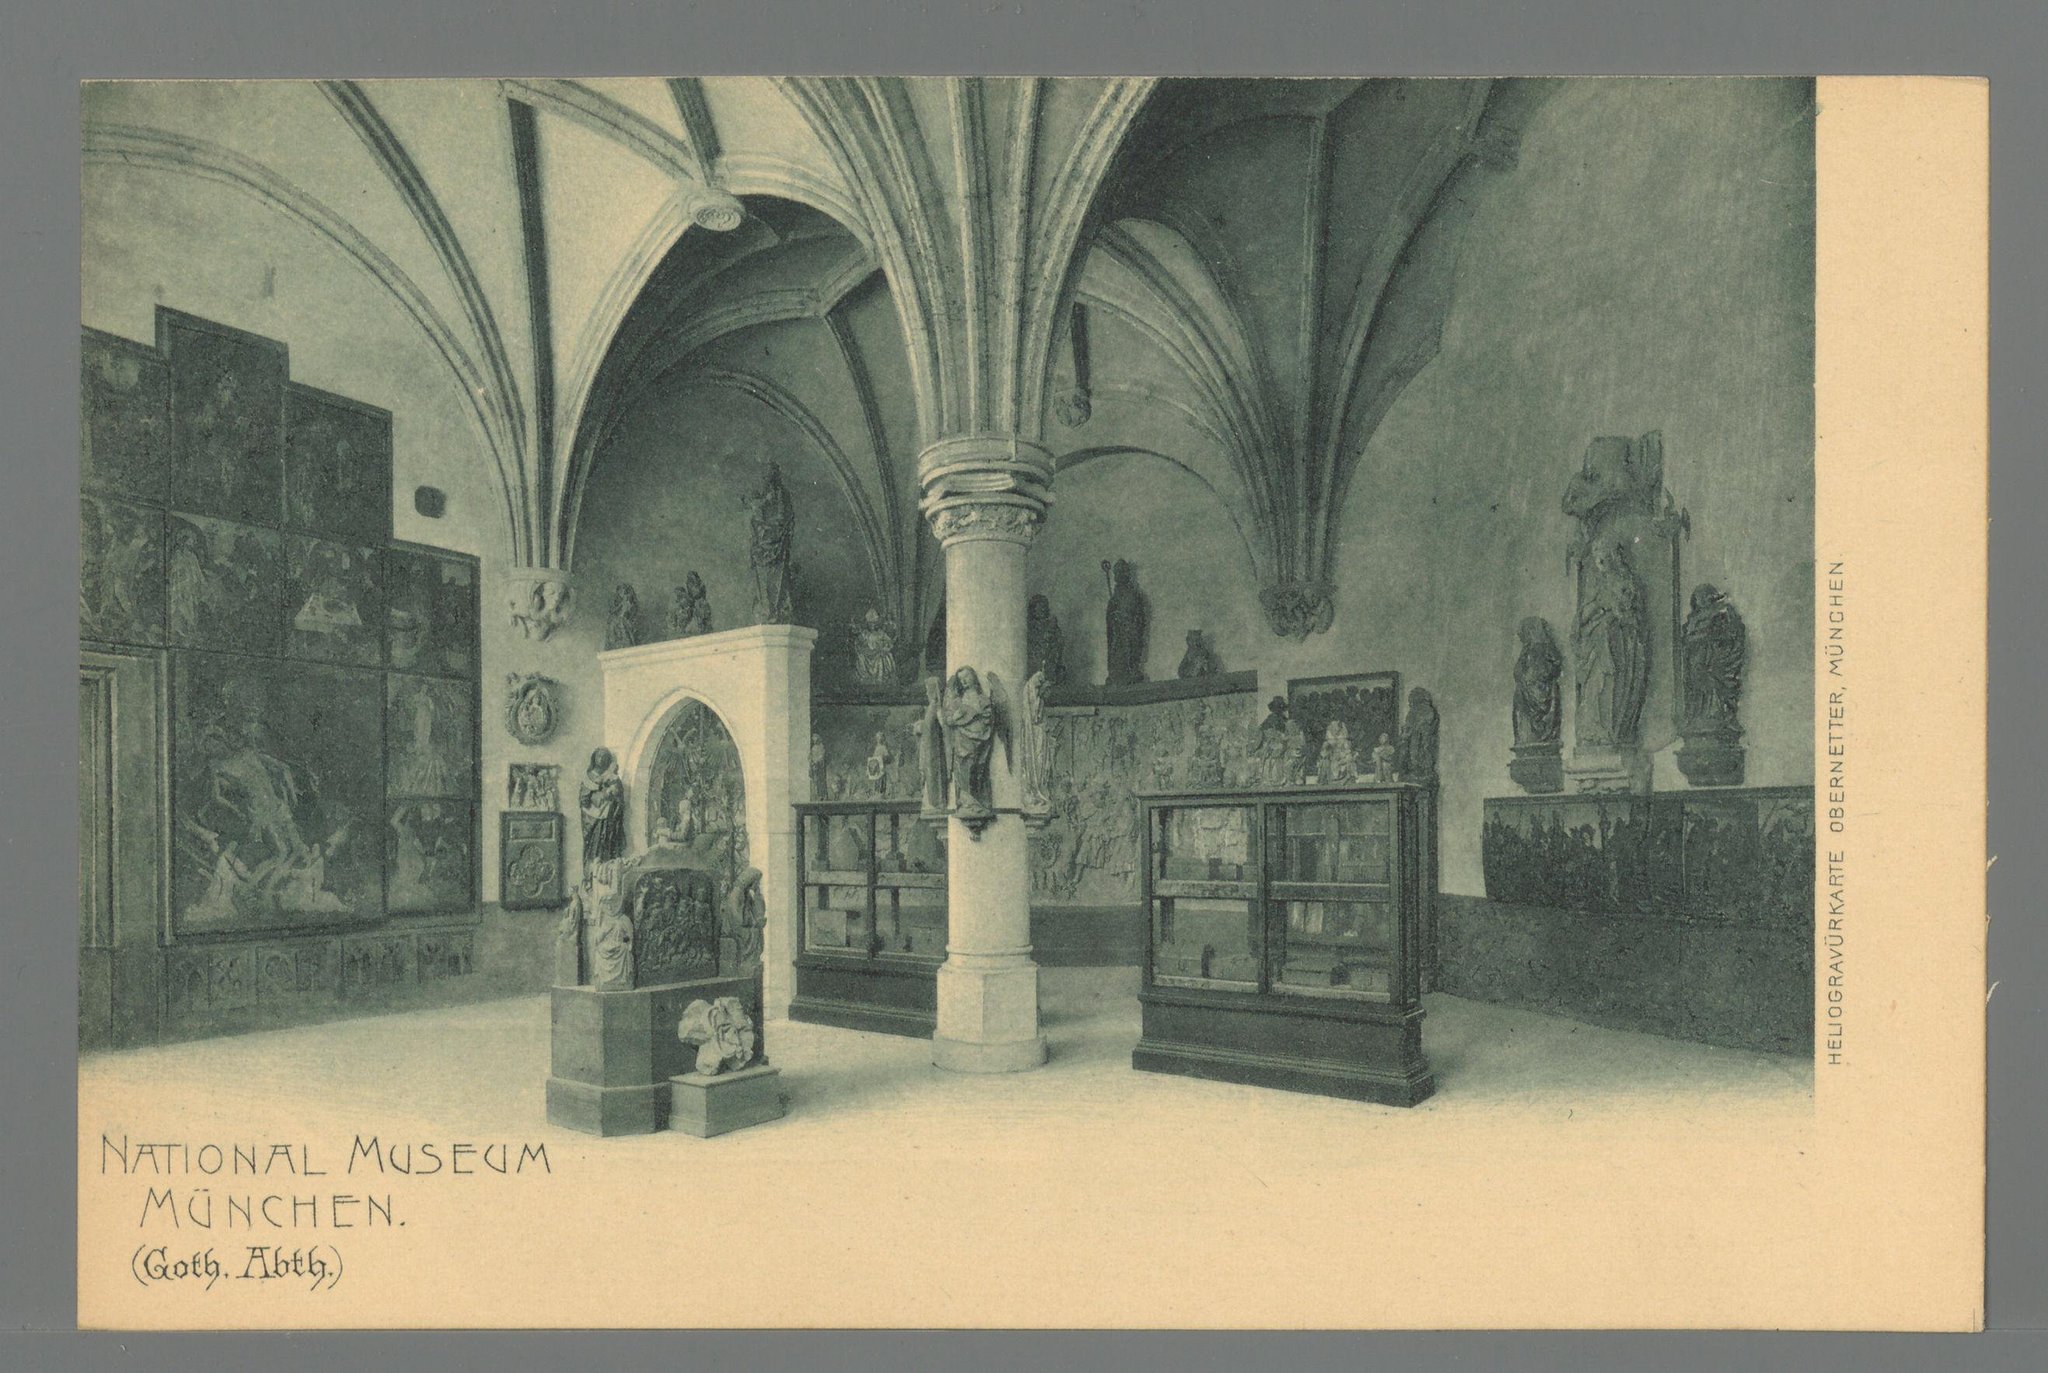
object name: photomechanical print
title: National Museum München. (Goth. Abth)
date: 1885-1905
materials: cardboard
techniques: photoaquatint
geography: munich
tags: permanent exhibition, museum